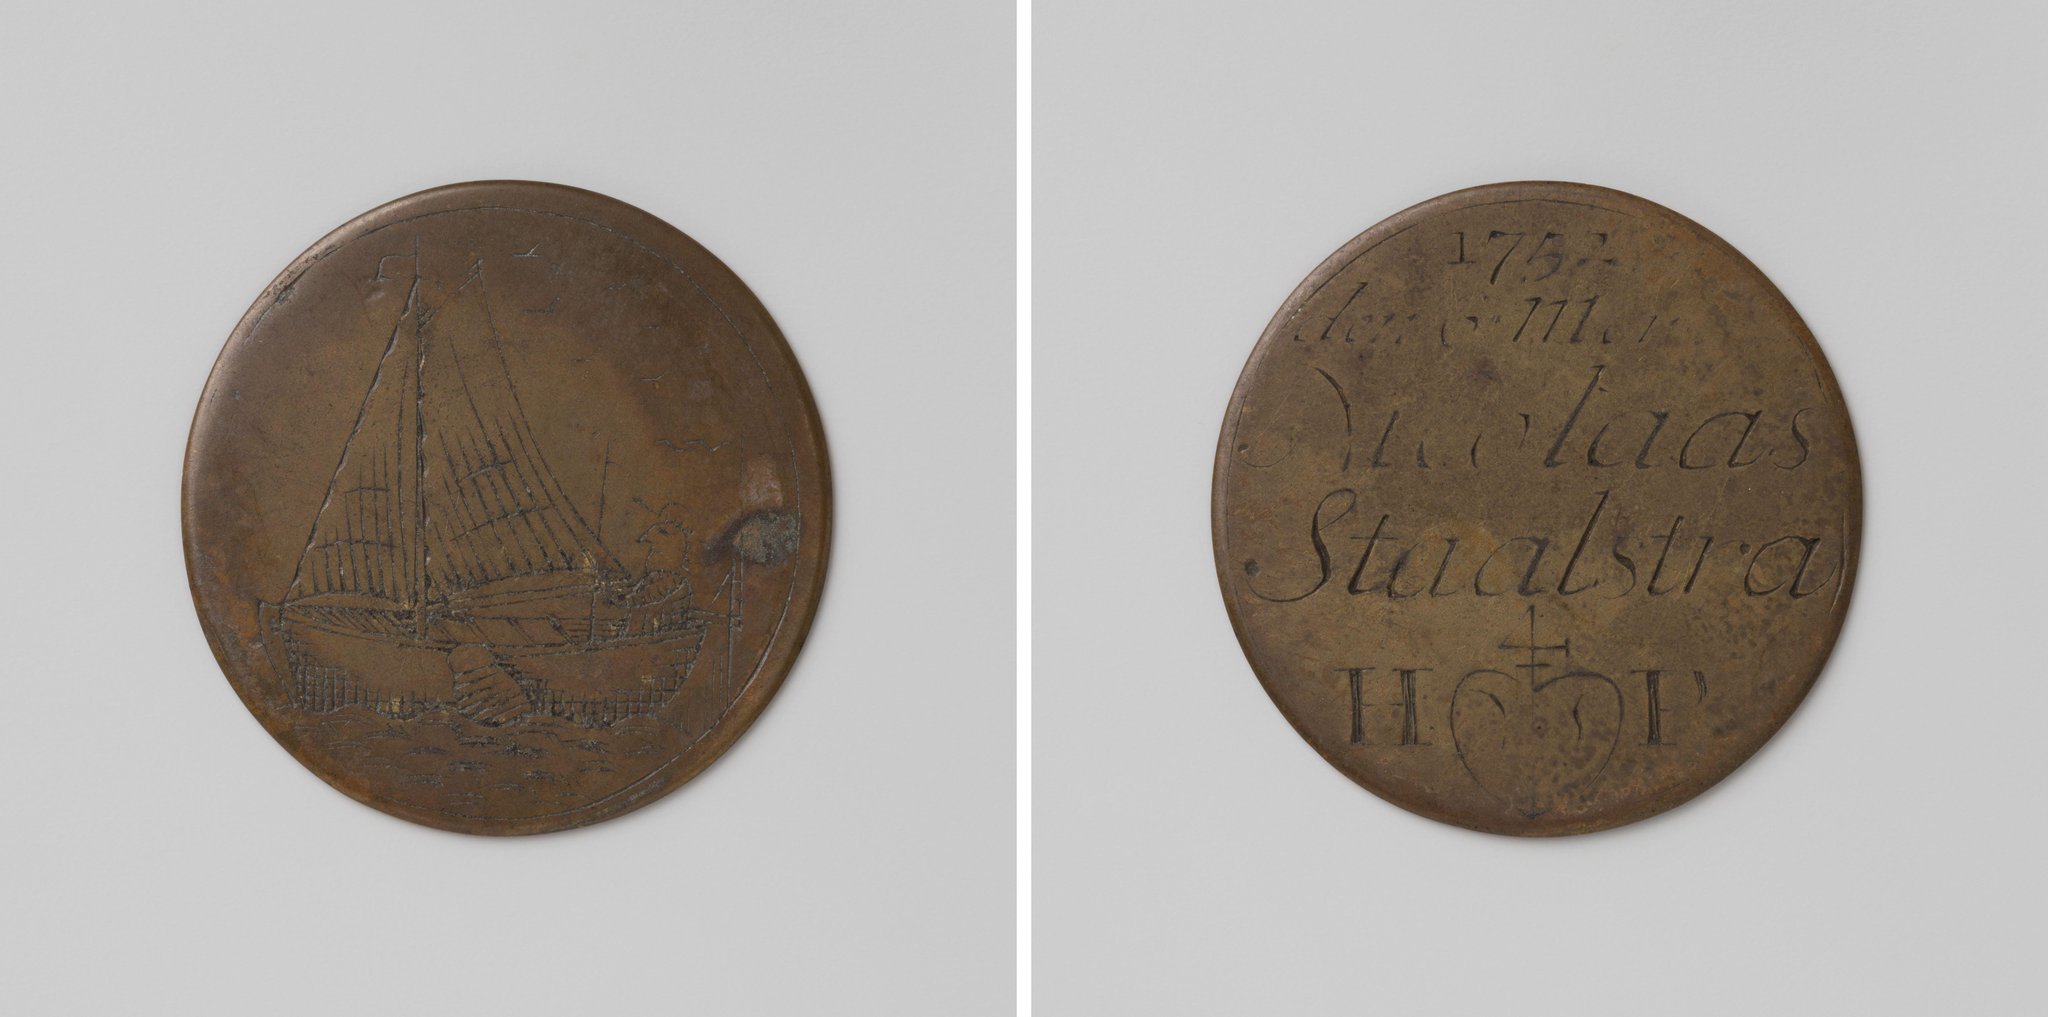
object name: medal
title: Roei-, steiger- en schuitenvoerdersgilde van Amsterdam, gildepenning van Nicolaas Staalstra, ligplaats Haringpakkerij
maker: Anonymous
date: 1752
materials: brass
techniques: engraving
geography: amsterdam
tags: amsterdam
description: Messing penning. Voorzijde: naar links varende zeilboot; op achterplecht: zittende man. Keerzijde: opschrift boven huismerk en hart met daarin letters N en S tussen monogram van letters H en P